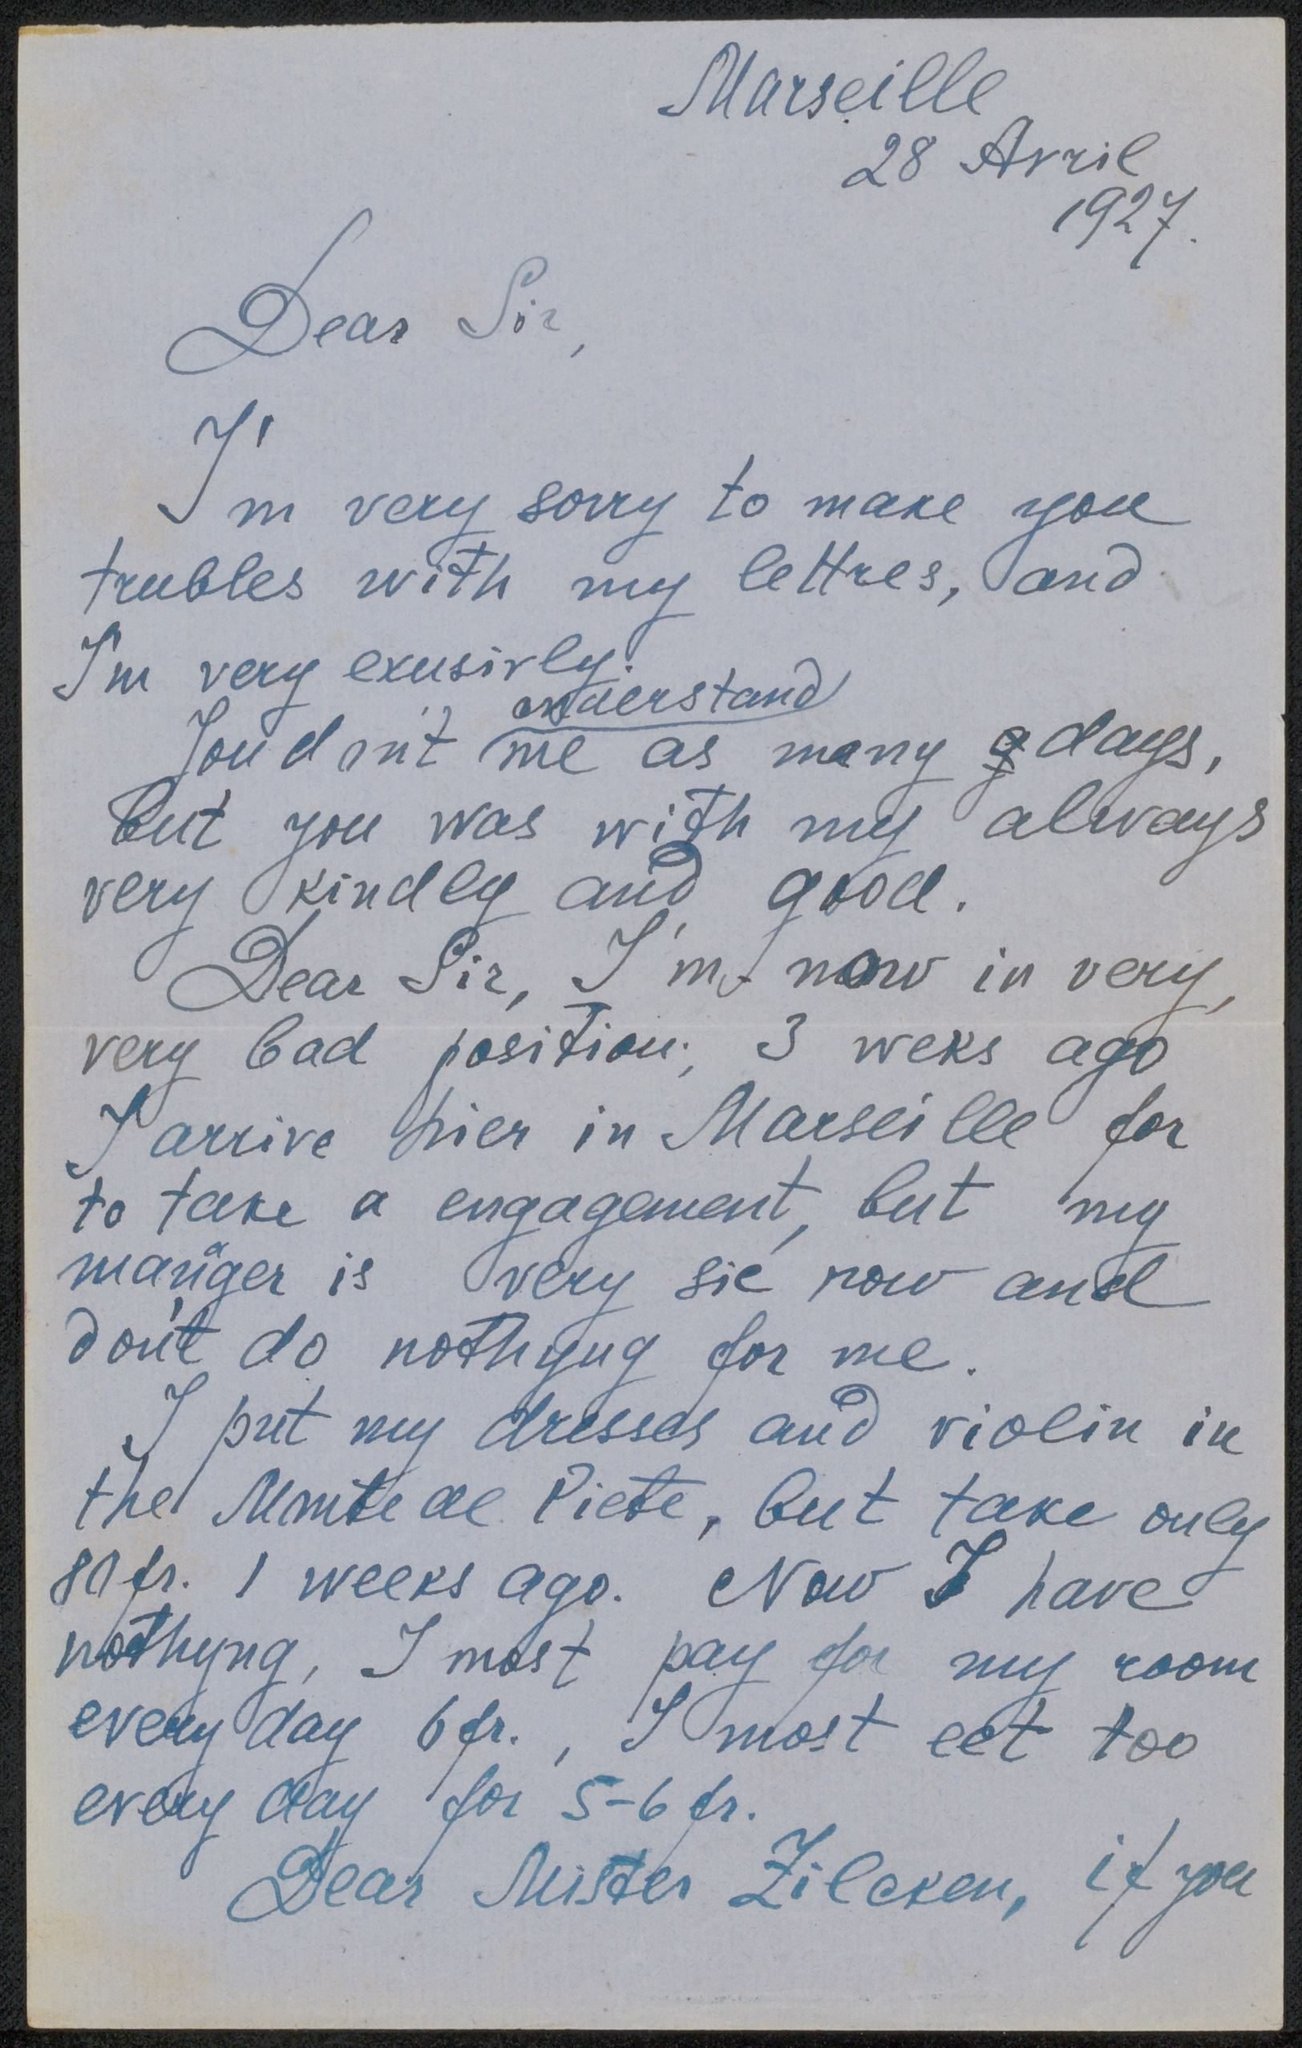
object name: letter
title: Brief aan Philip Zilcken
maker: edouard lipping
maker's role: balletdanser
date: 1927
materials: ink, paper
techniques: pen, writing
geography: marseille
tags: painter, draughtsman, philip zilcken, the arts of the stage: ballet, theatre, musical drama, motion picture, money, marseille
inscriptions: collector's mark: ‘RPK’